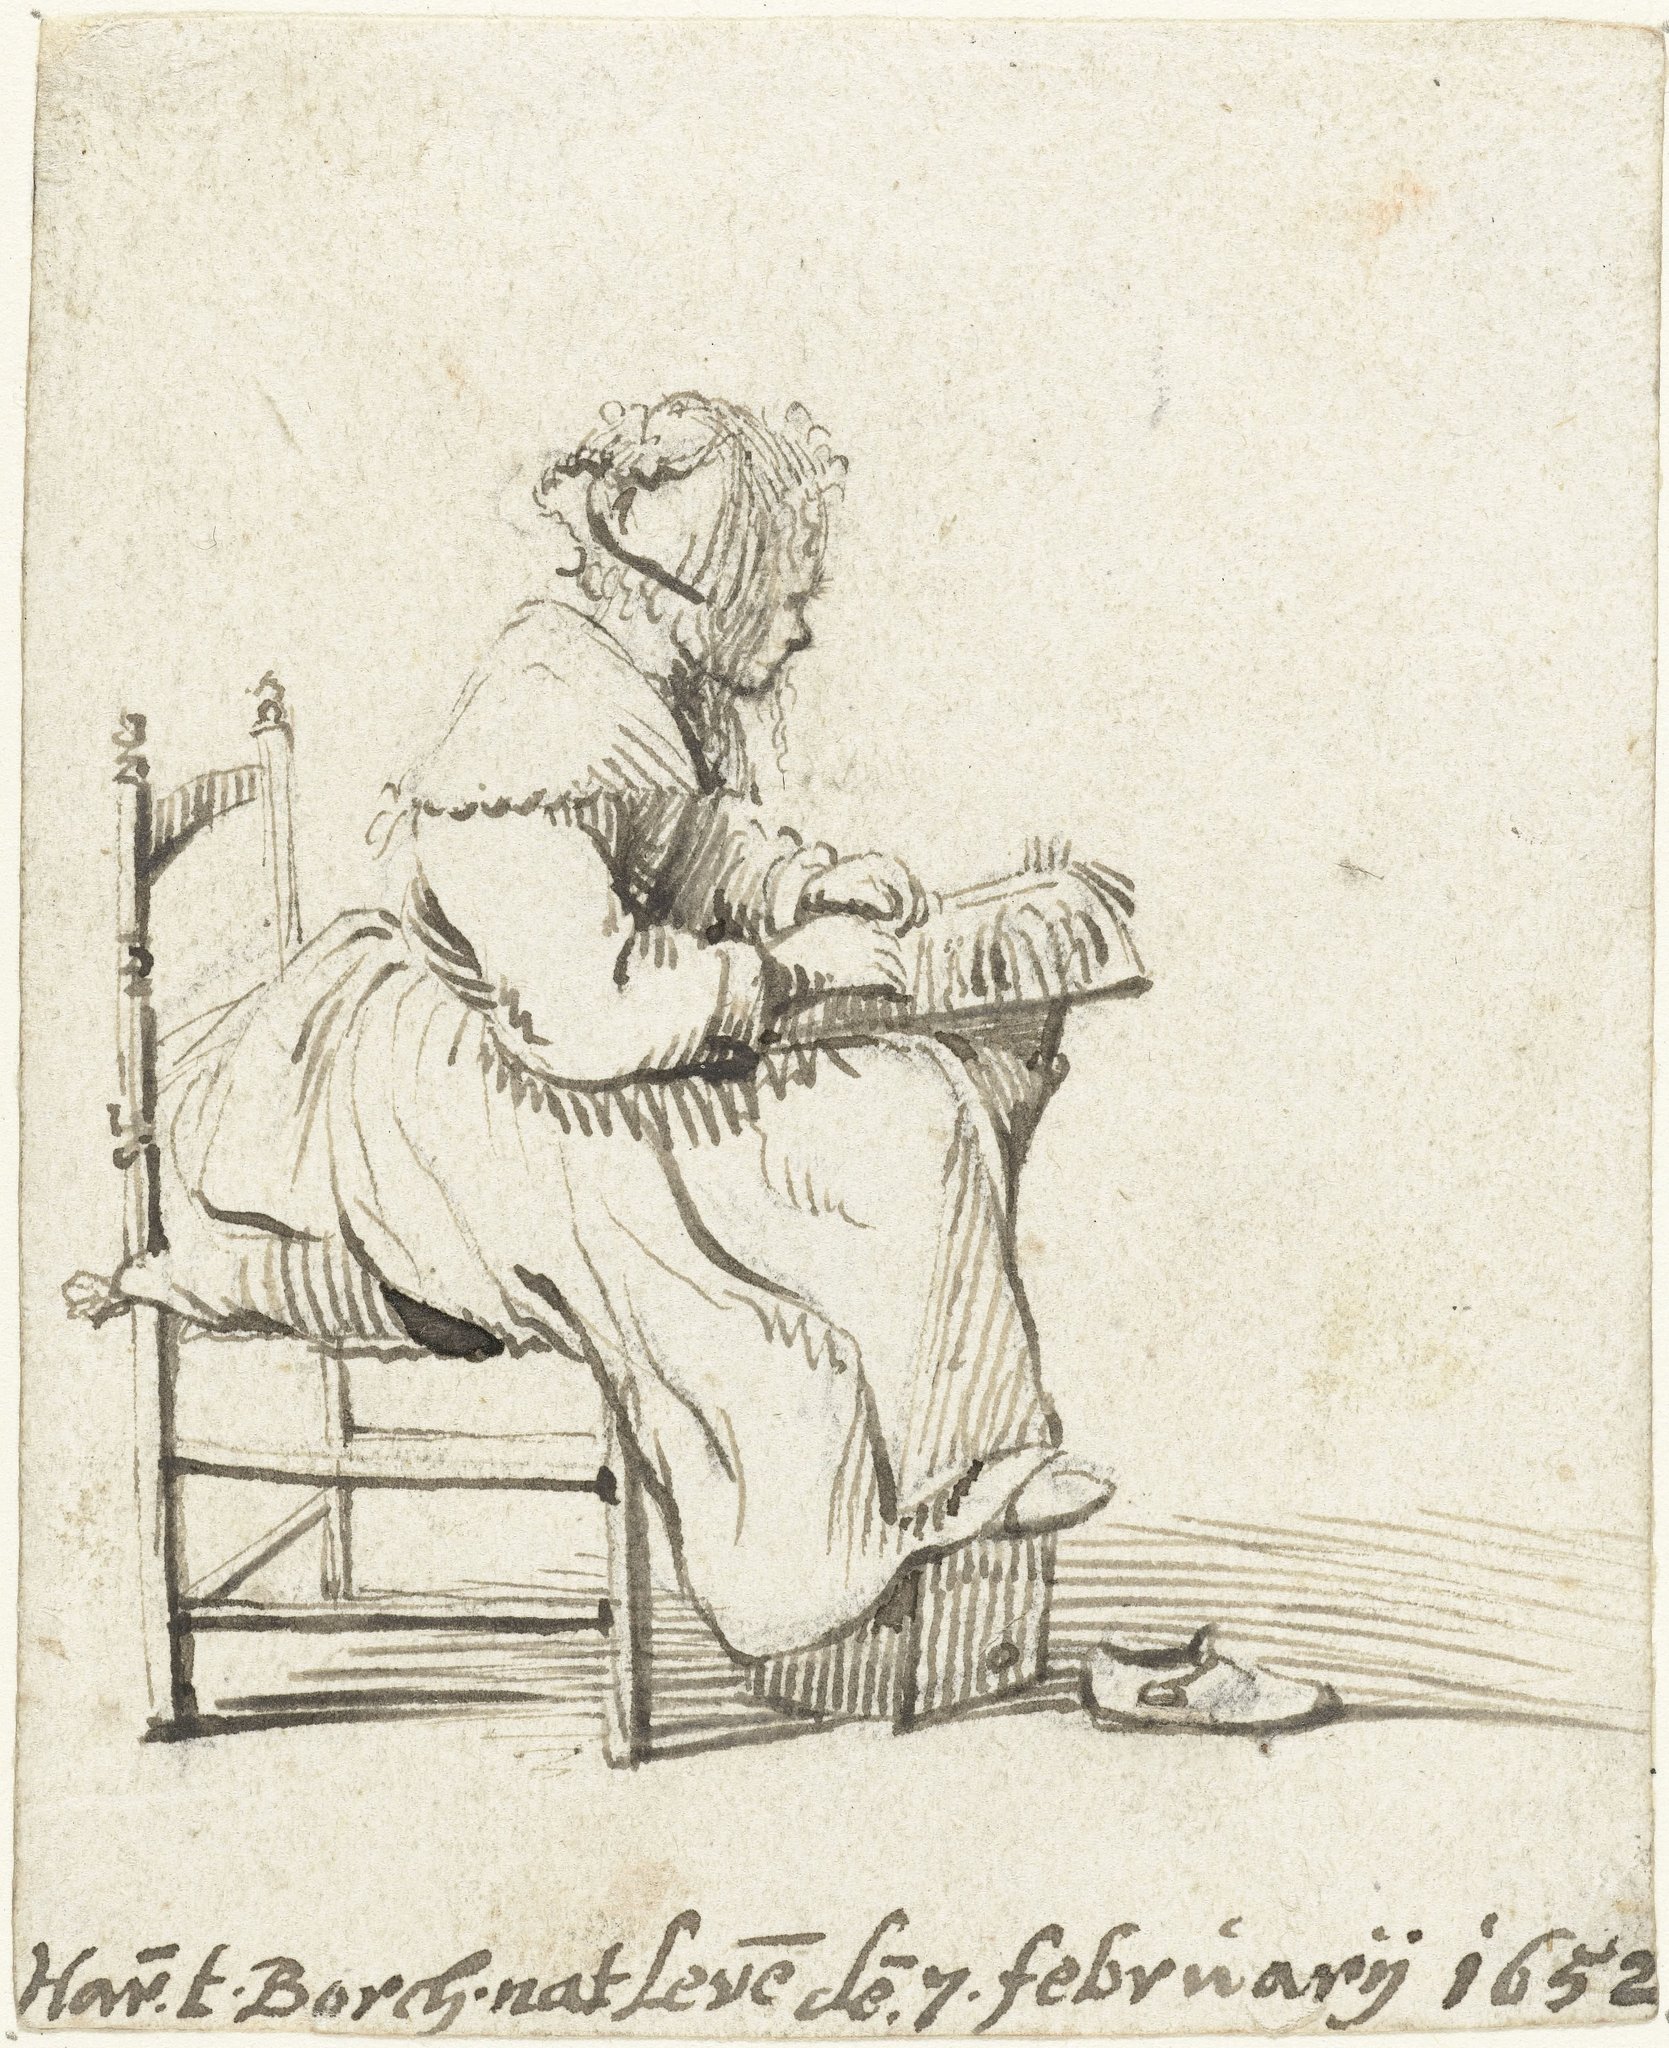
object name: drawing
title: Jonge vrouw bezig met het maken van kant, in profiel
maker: harmen ter borch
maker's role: draughtsman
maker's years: 1638-1677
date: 1652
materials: chalk, ink, paper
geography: zwolle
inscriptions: annotation: ‘Har[man]. t.Borch. nat leve[n] den.7.februarij 1652’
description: Jonge vrouw op een stoel, bezig met het maken van kant, in profiel.